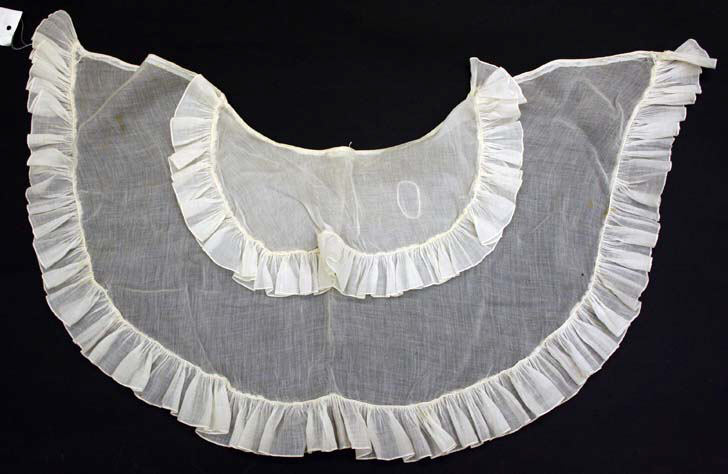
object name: pelerine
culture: american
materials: cotton